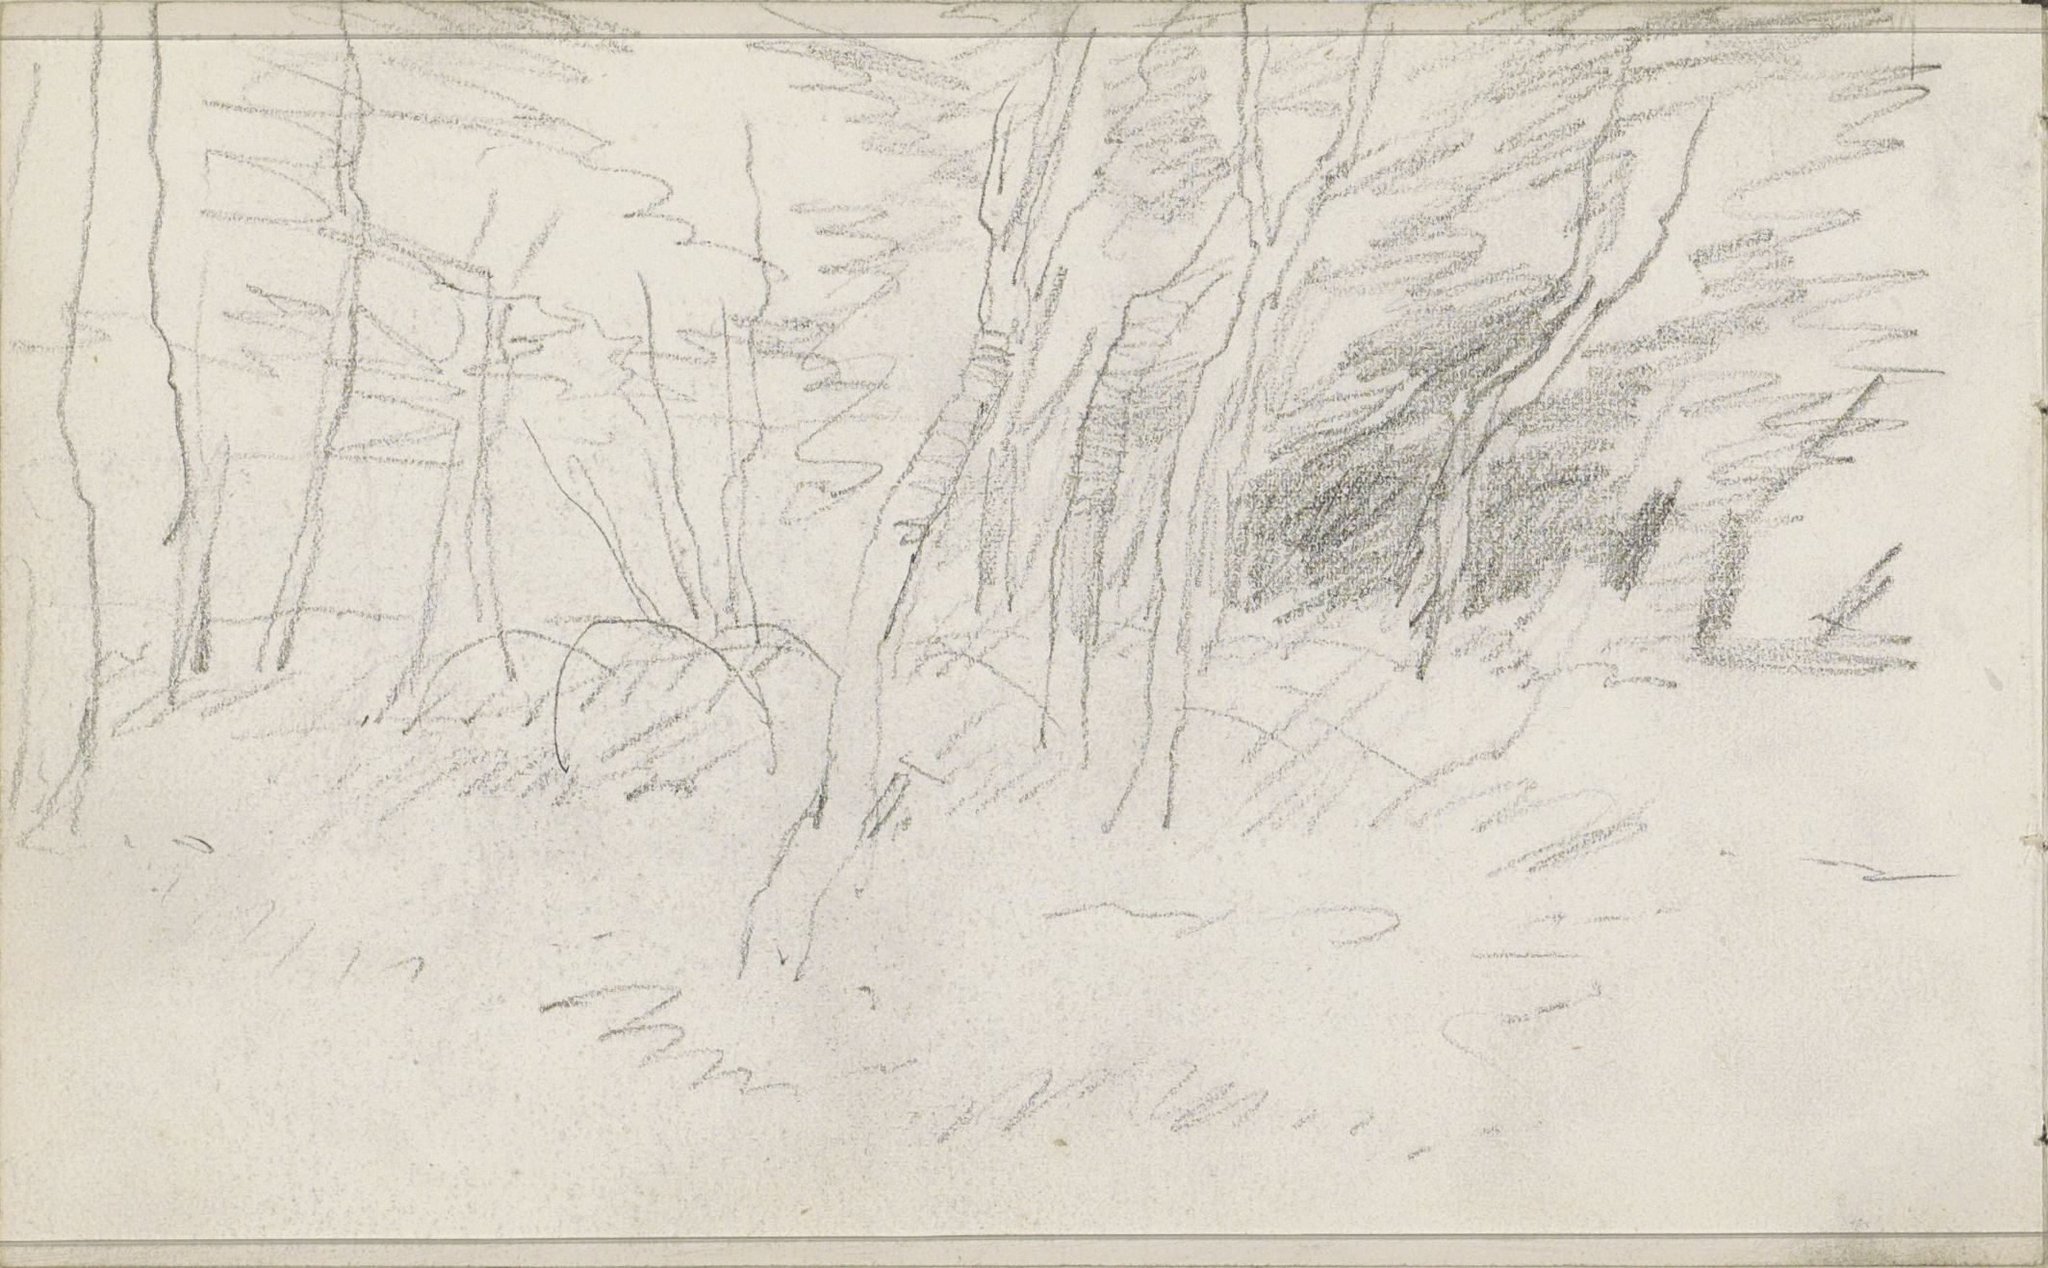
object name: sketchbook leaf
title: Landschap met bomen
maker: anton mauve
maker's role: draughtsman, painter, print maker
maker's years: 1838-1888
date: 1848-1888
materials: paper, pencil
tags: trees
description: Blad 16 verso uit een schetsboek met 43 bladen.